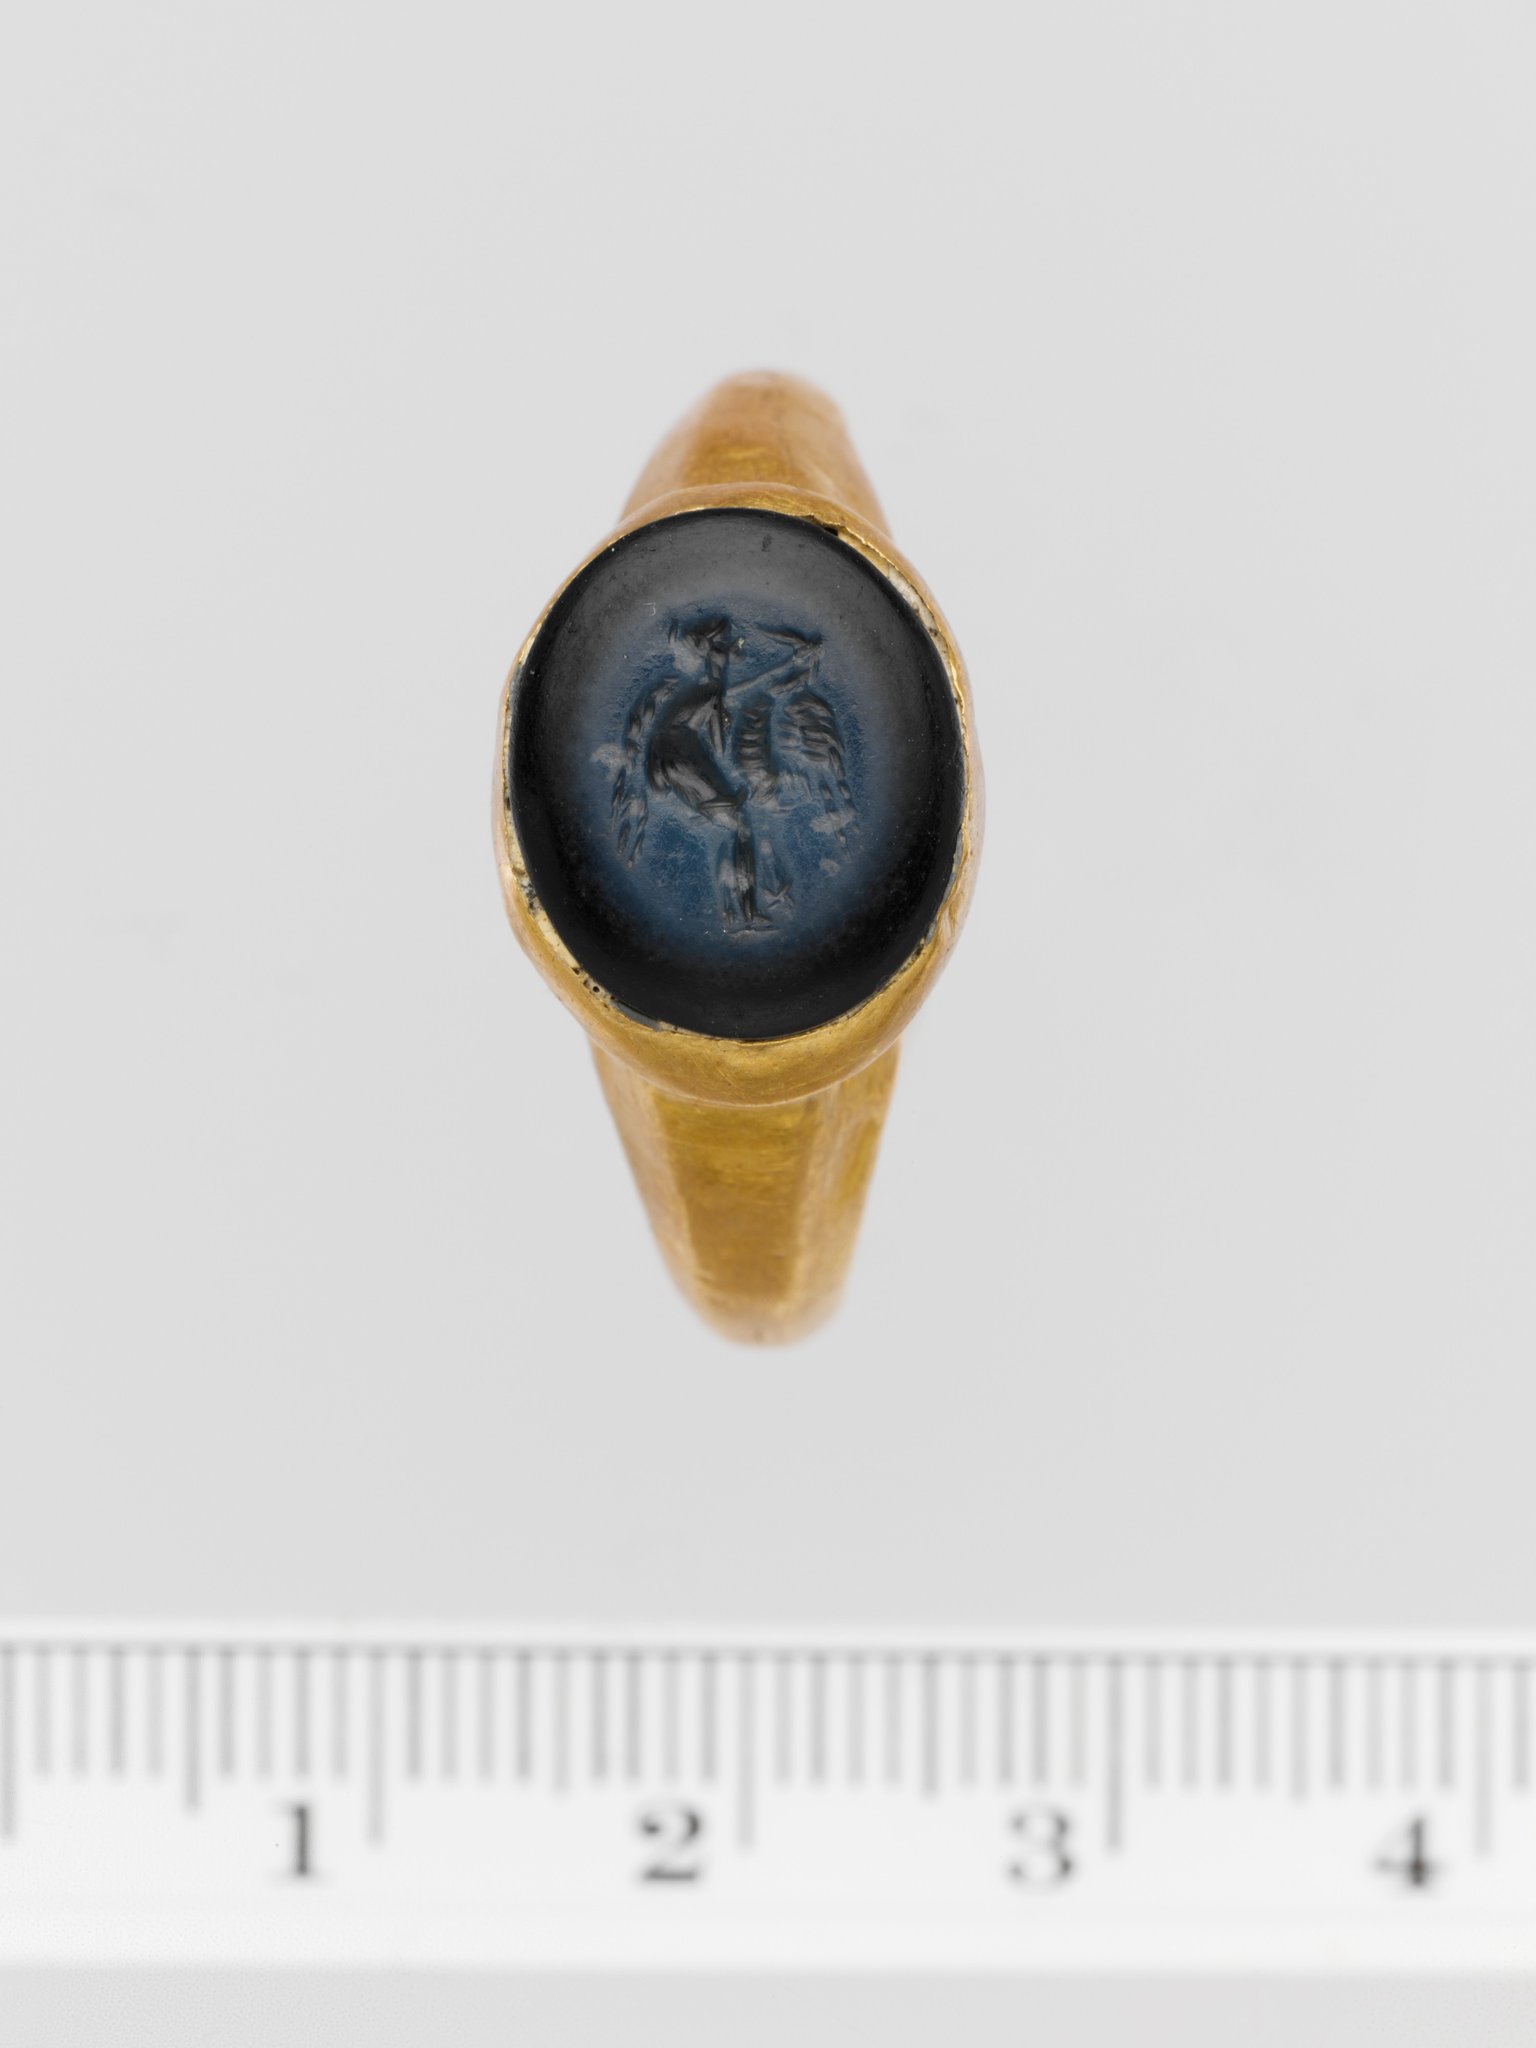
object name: intaglio in ring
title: Nicolo ring stone set in a gold ring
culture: roman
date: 1-200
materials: gold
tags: leda,swans